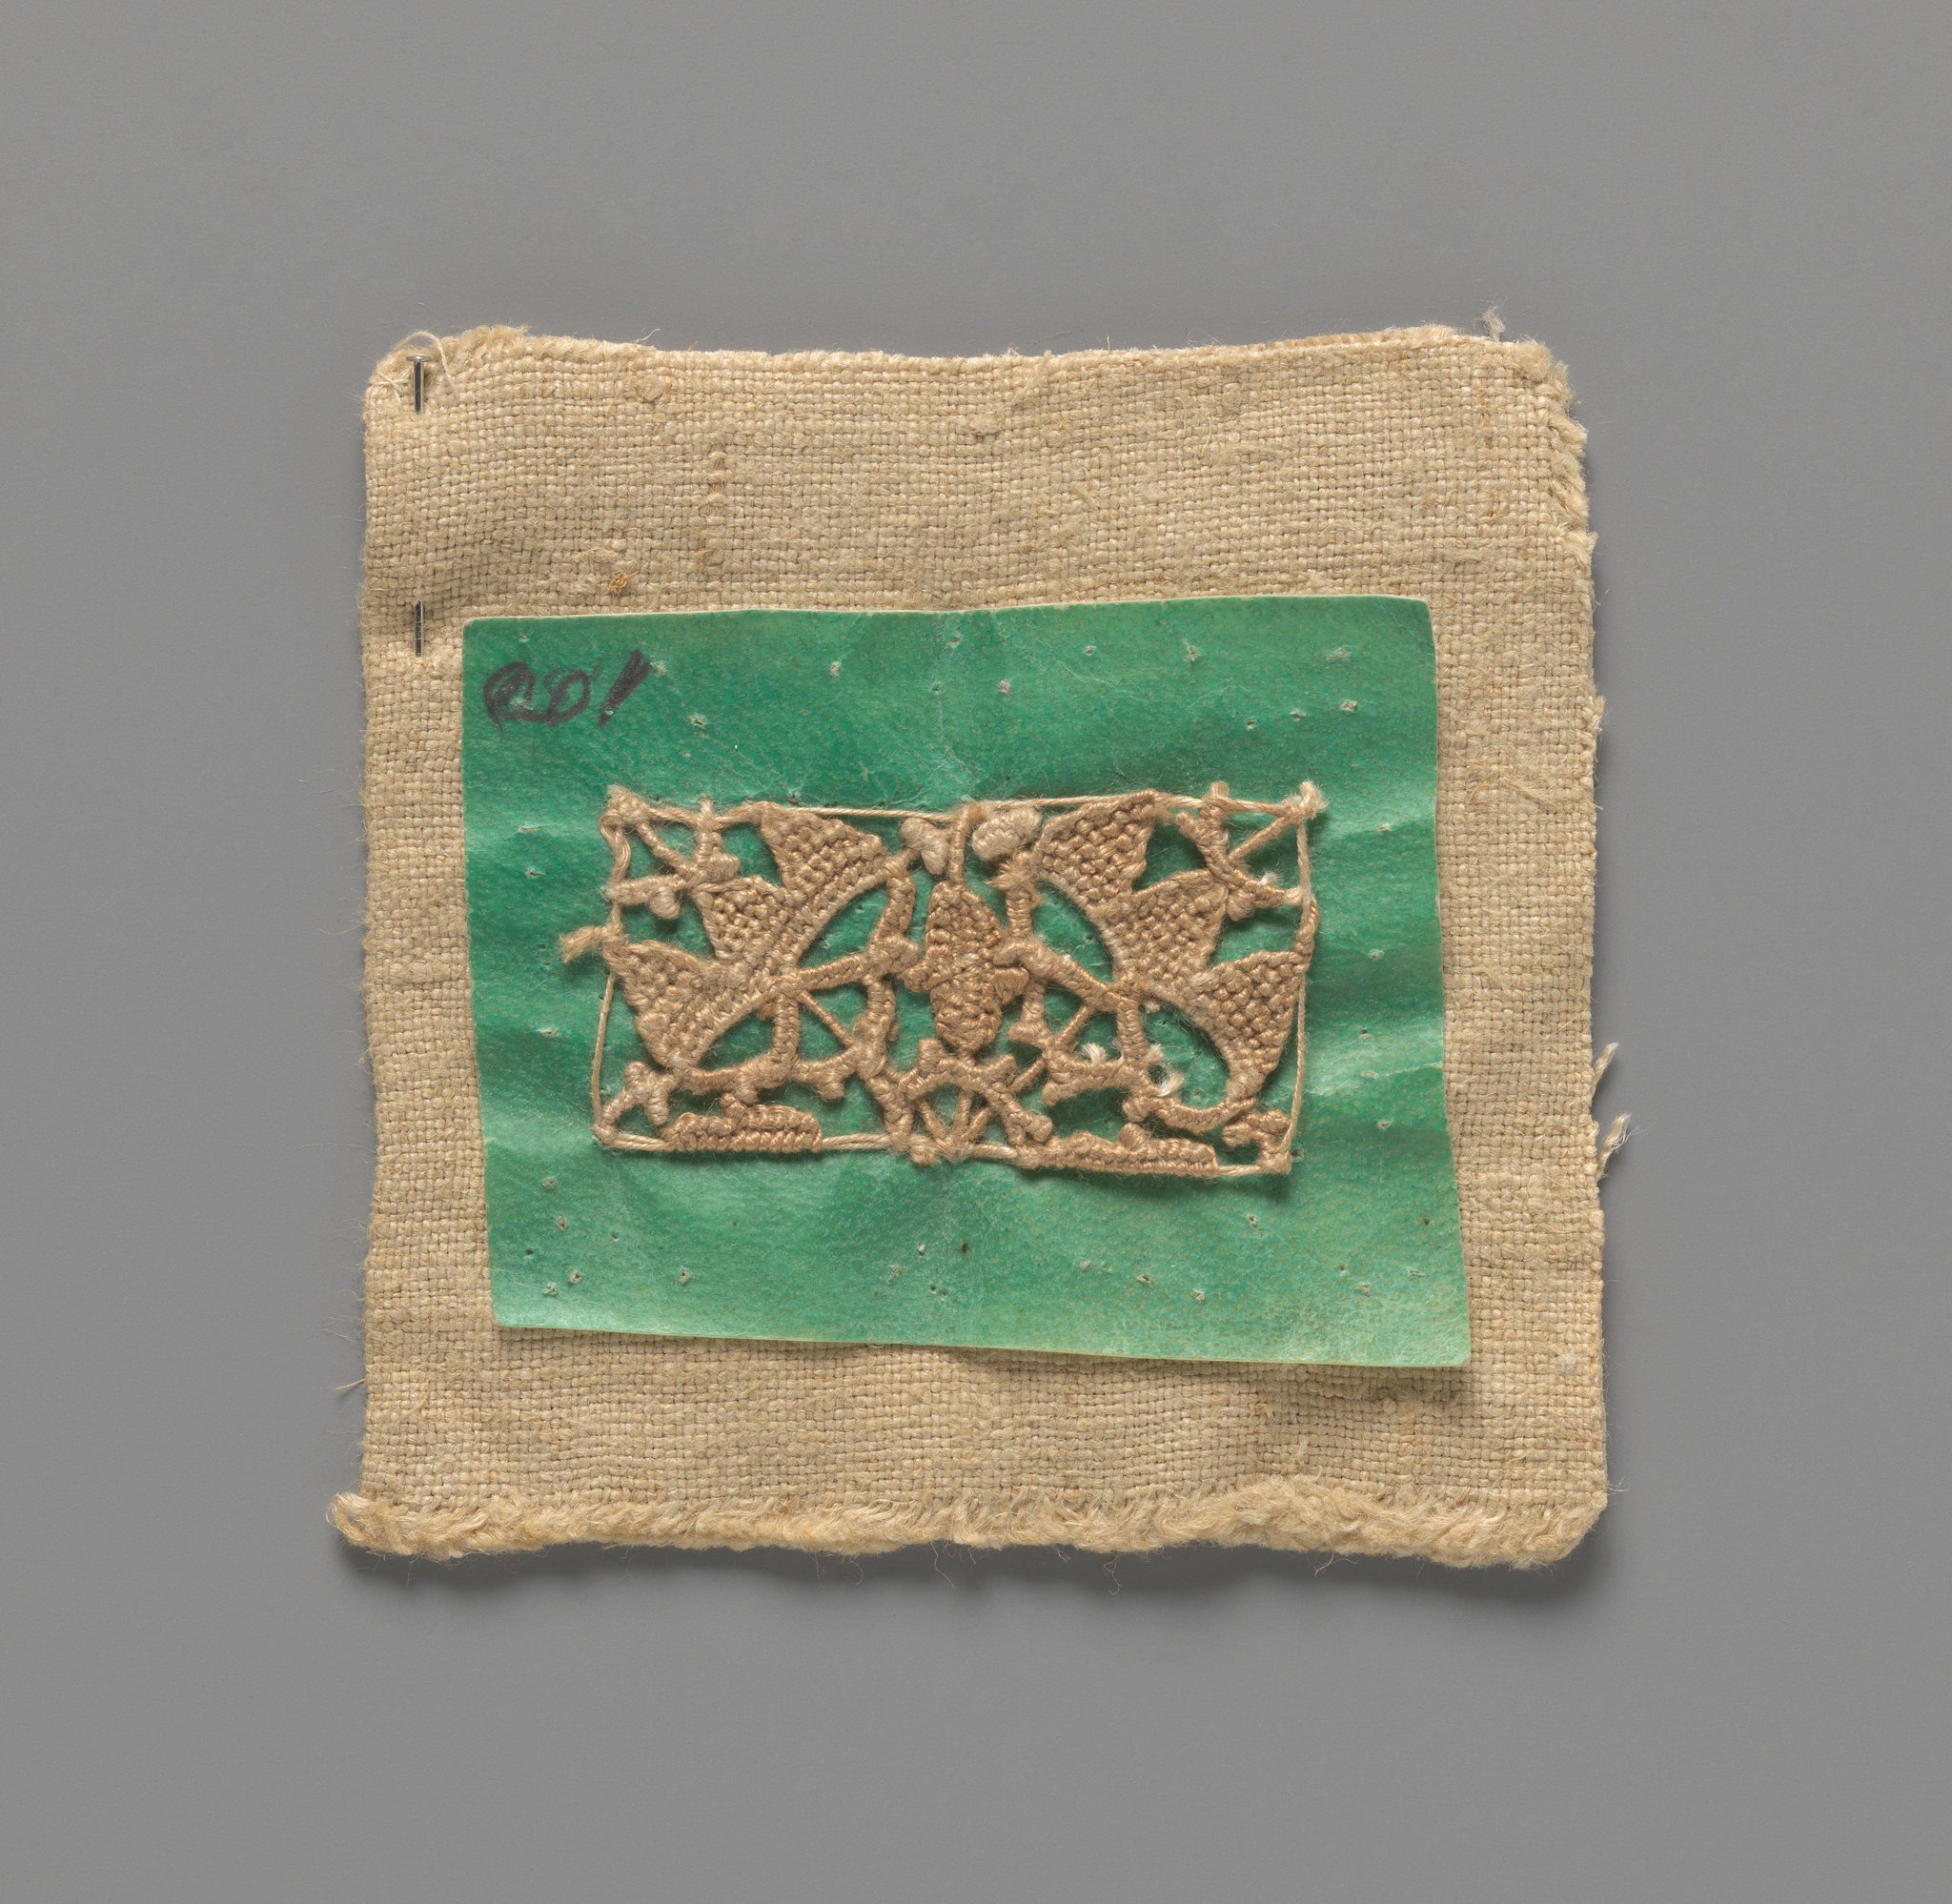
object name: tool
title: Gereedschap voor een naaldkantmotief in de vorm van kleermakerslinnen waarop groen perkament is genaaid met een bijna voltooid motief in reticella-techniek met spandraden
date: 1906-1910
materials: linen, parchment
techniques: sewing, weave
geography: the hague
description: Gereedschap voor een naaldkantmotief in de vorm van kleermakerslinnen waarop groen perkament is genaaid met een bijna voltooid motief in reticella-techniek met spandraden. Het motief betreft een rechthoek van spandraden, die in twee vierkanten is gedeeld die elk met diagonale lijnen weer in vieren is gedeeld. Vervolgens is een reticella-patroon gemaakt met driehoekjes, een ovaaltje, een wiel en trensjes. Op het perkament staat geschreven met potlood: "1,00".